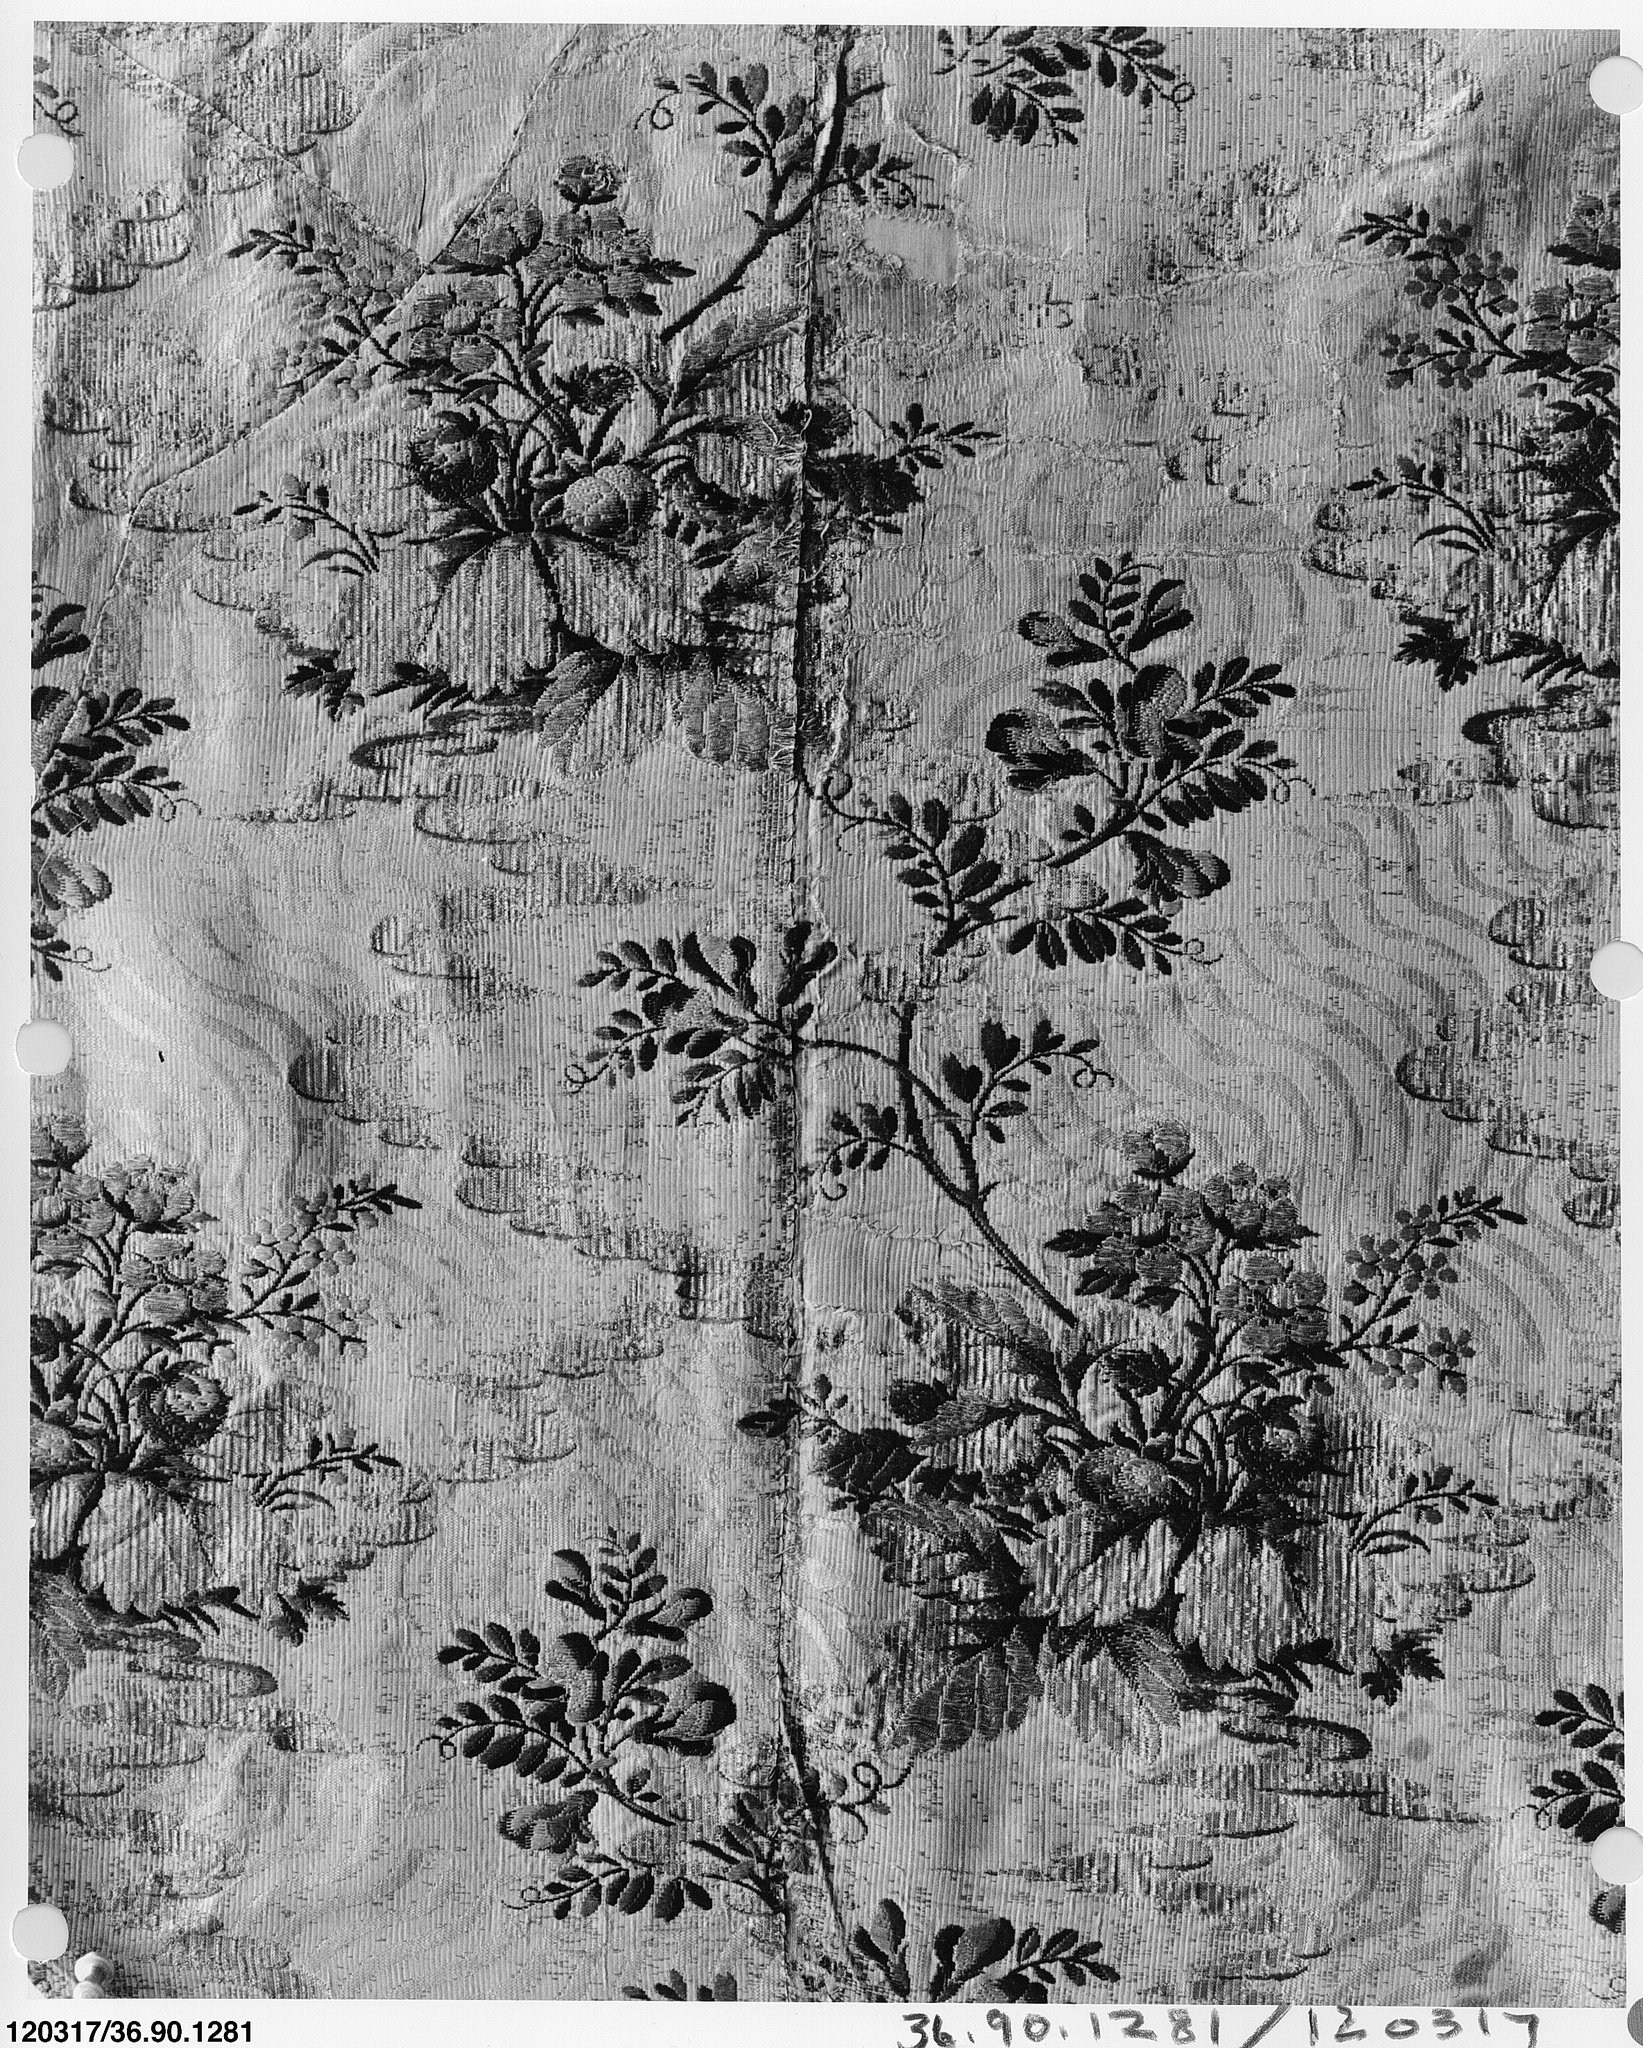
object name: piece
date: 1750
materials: metal thread, silk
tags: flowers,leaves